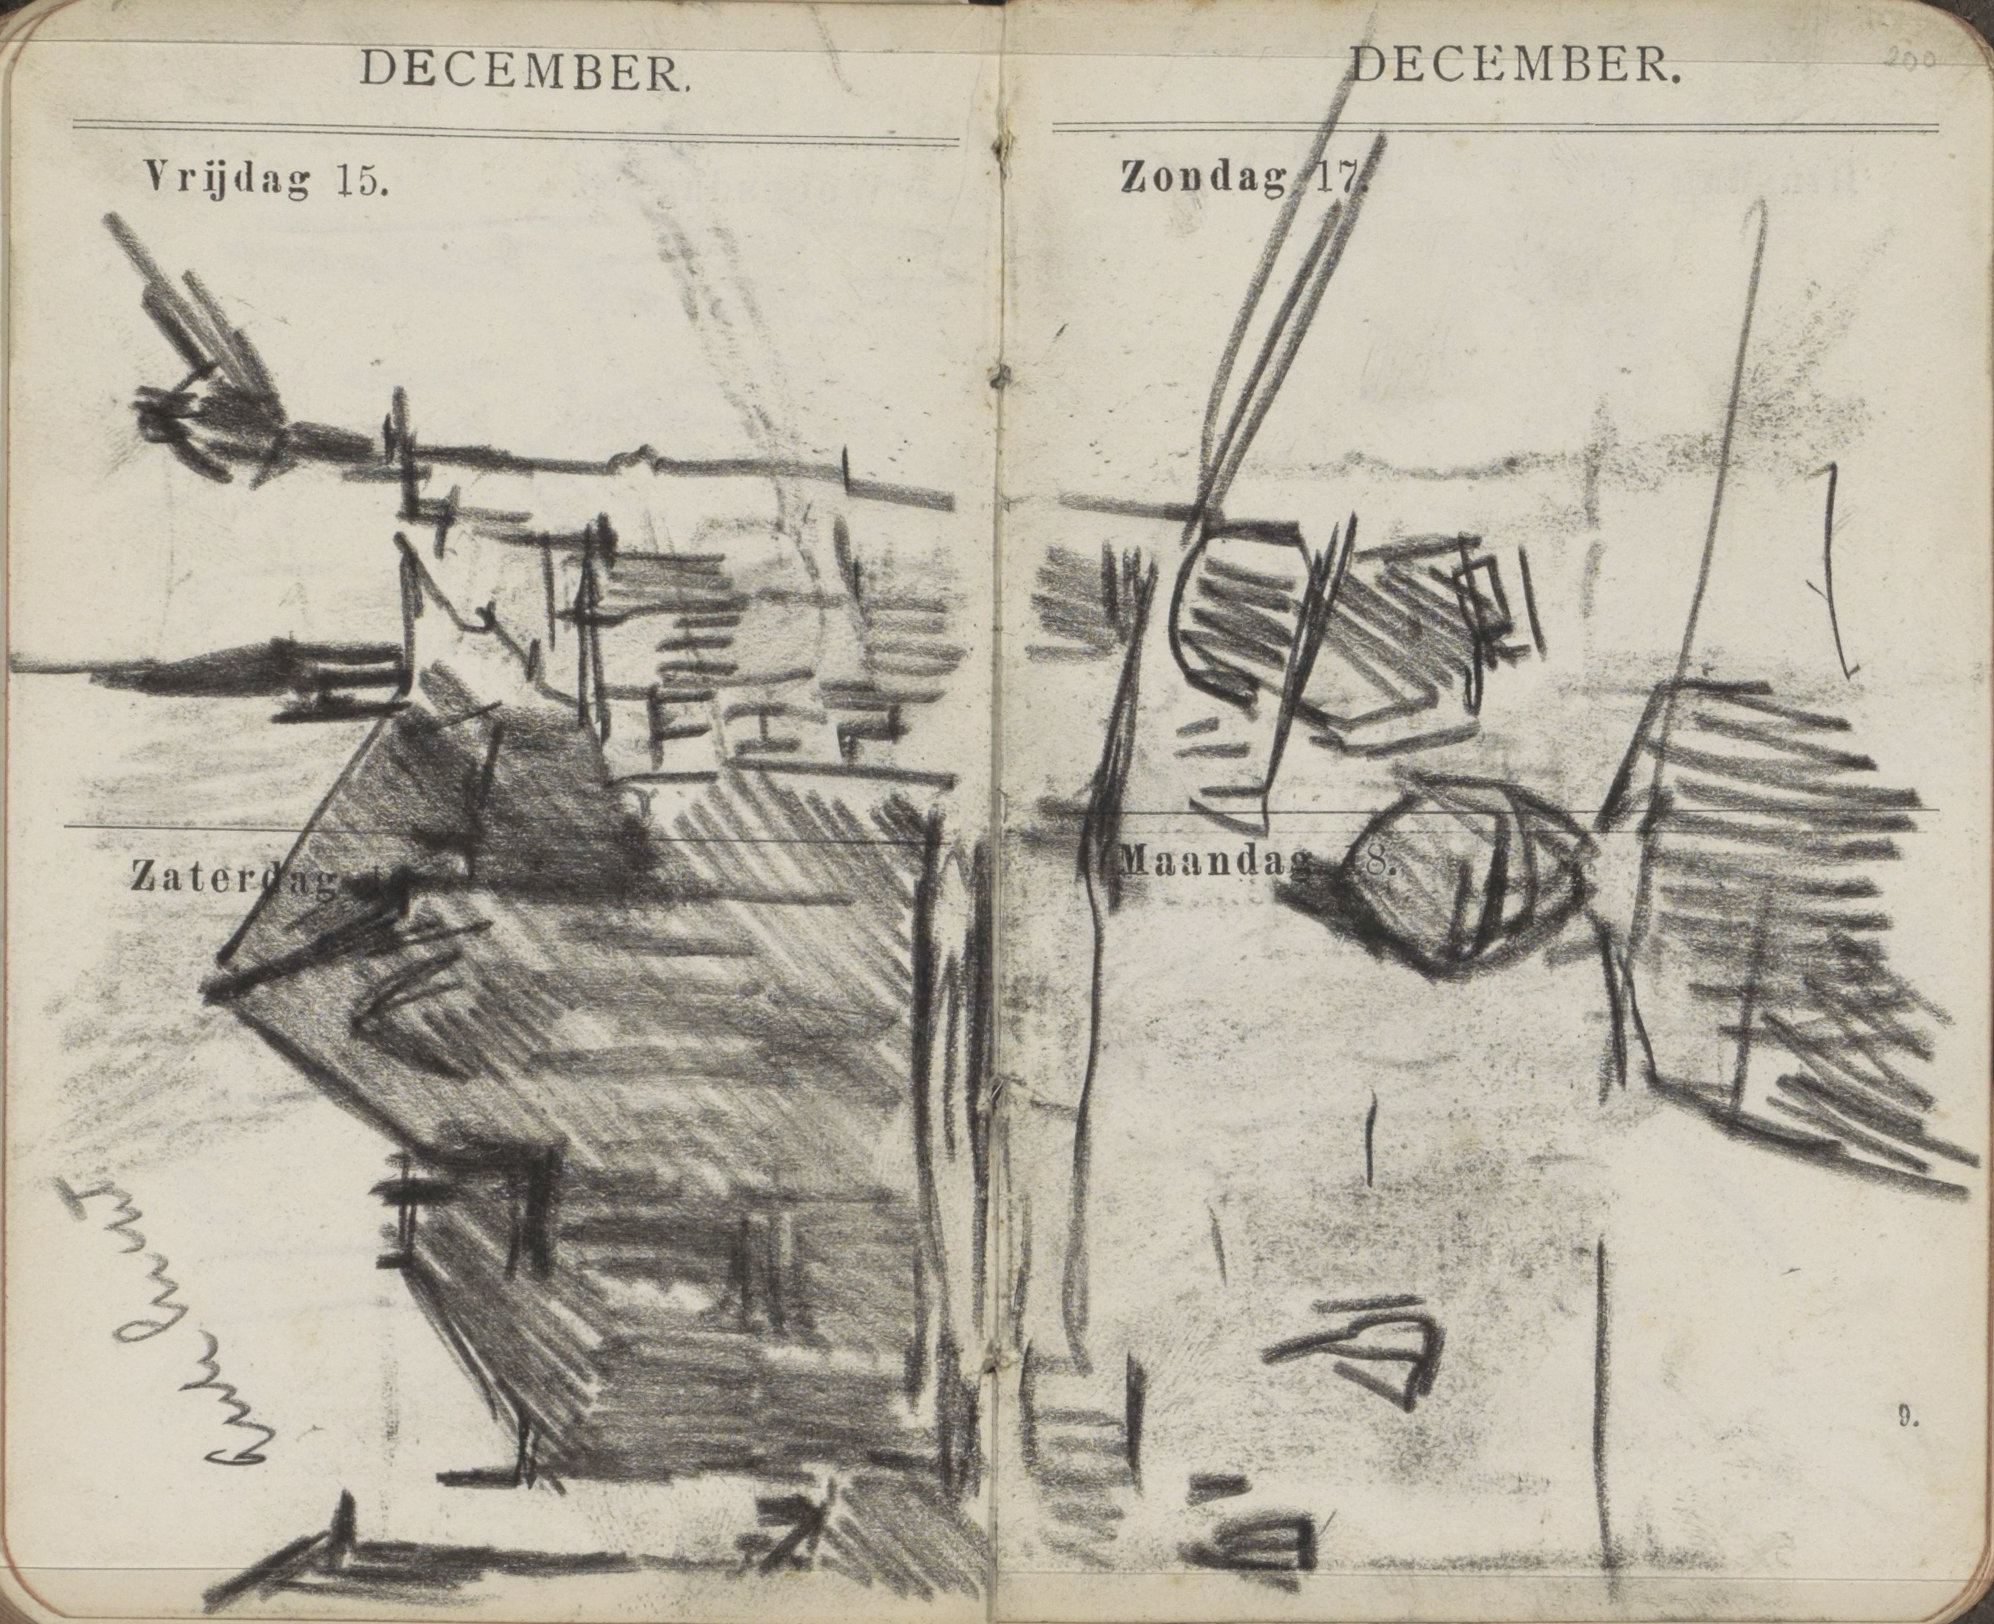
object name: sketchbook leaf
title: Gezicht op de Dam te Amsterdam met de Nieuwe Kerk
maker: george hendrik breitner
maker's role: draughtsman, painter, print maker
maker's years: 1857-1923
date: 1893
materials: chalk, paper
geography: amsterdam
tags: church (exterior), civic architecture; edifices; dwellings, square, place, circus, etc. (+ city(-scape) with figures, staffage), royal palace of amsterdam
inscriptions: : ‘geele lucht’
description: Links een deel van het Koninklijk Paleis. Vooraan een figuur. Pagina 199 en pagina 200 uit een als schetsboek gebruikte agenda met 108 bladen.